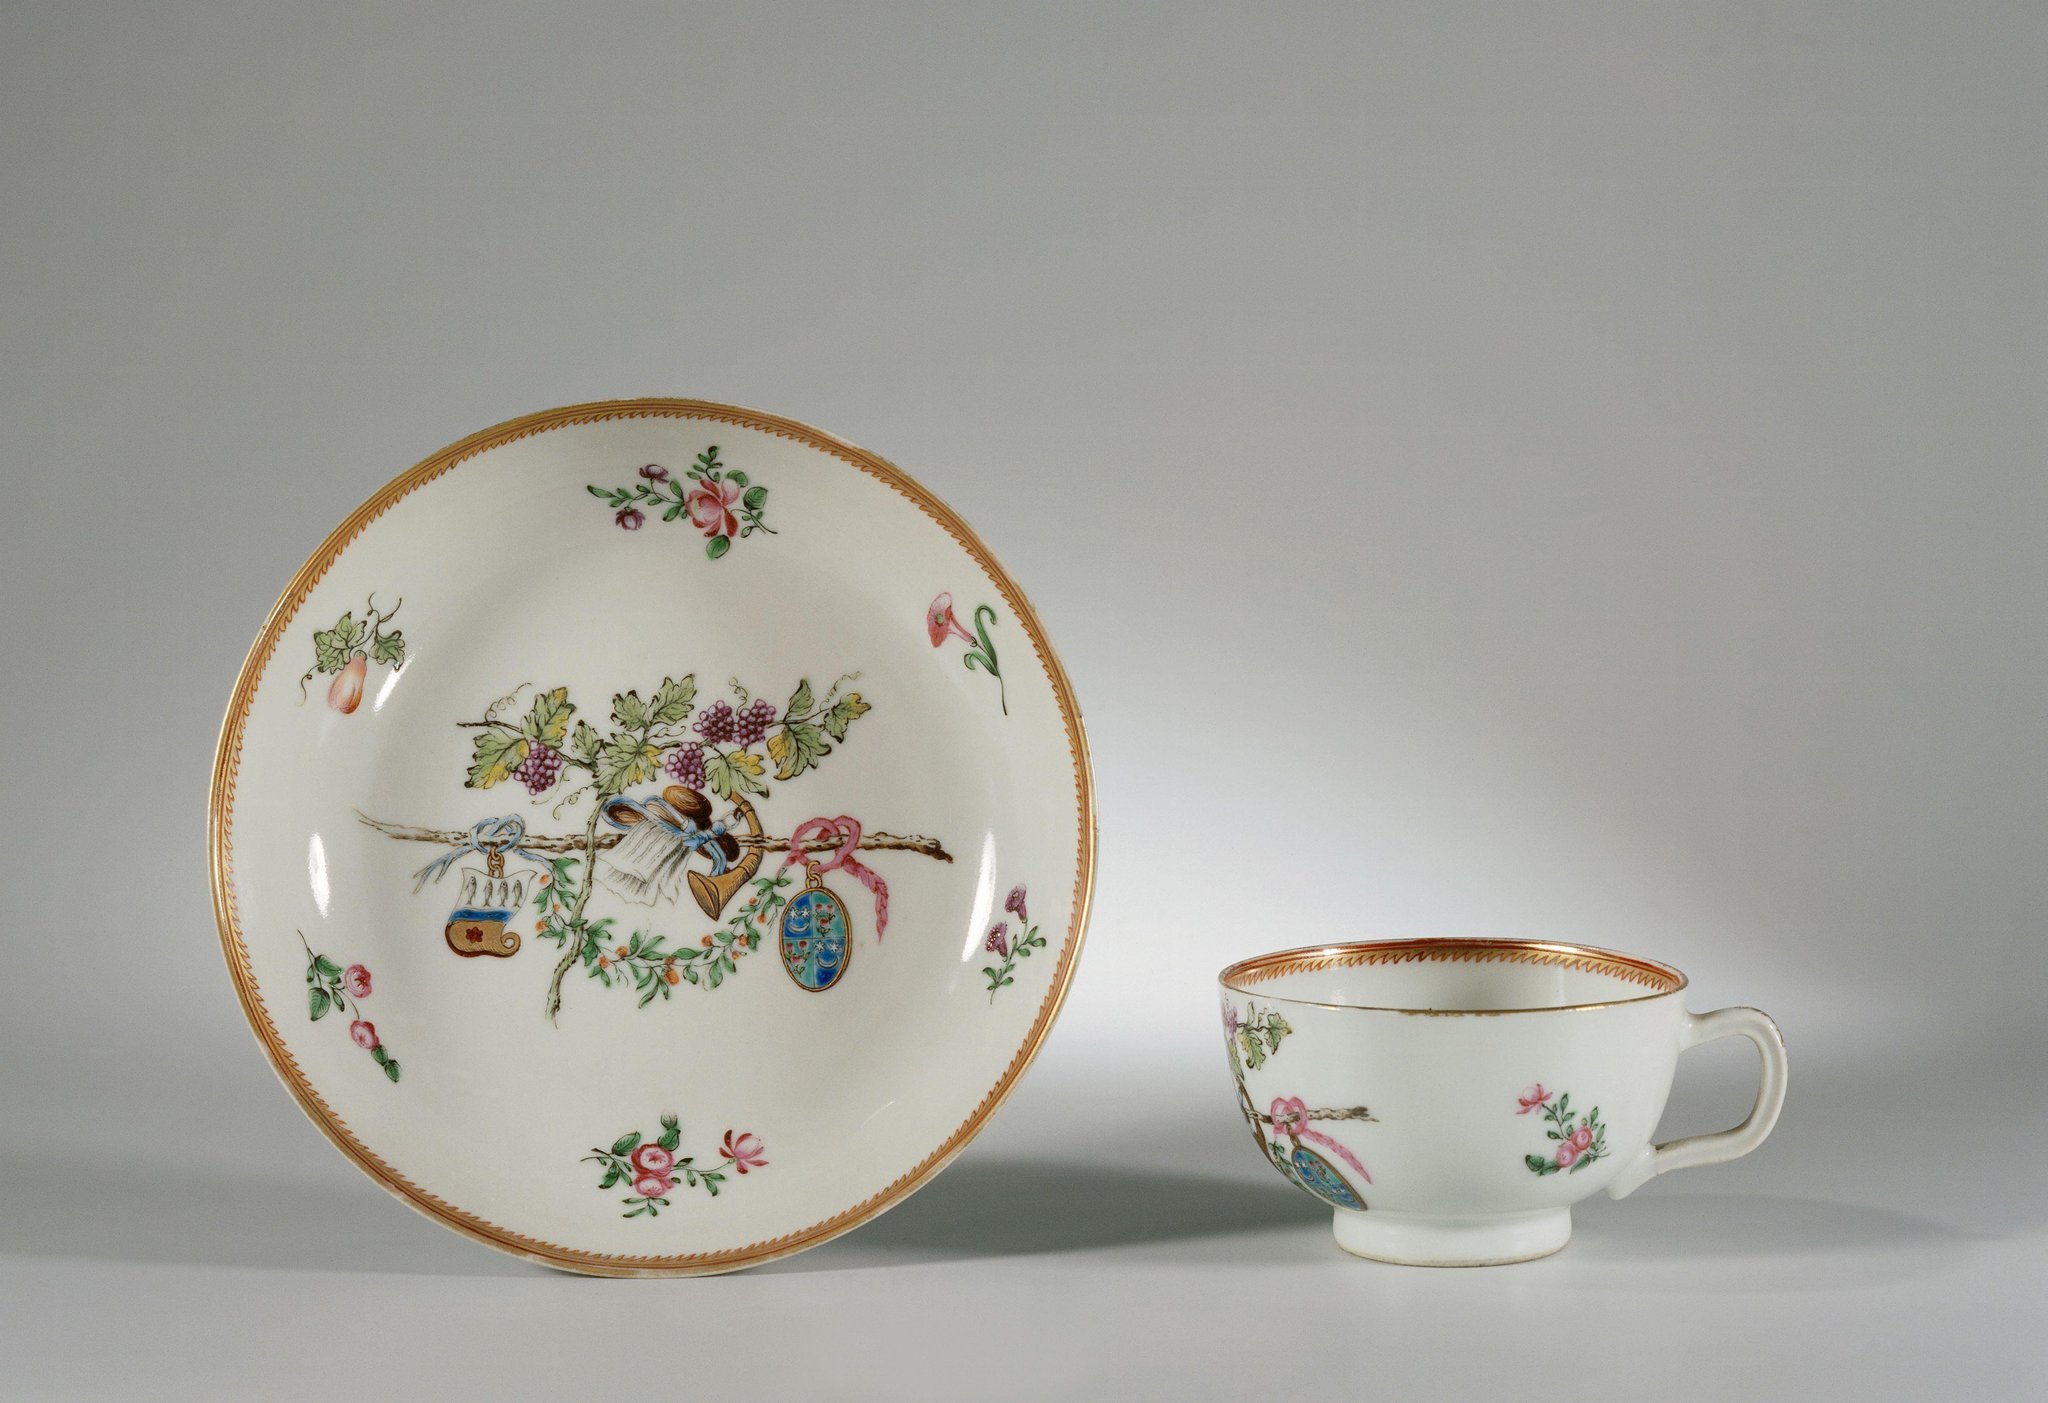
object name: cup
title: Cup with handle with the arms of the Visvliet and Sluymer families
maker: Anonymous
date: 1777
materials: glaze, gold, paint, porcelain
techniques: firing, gilding, turning, vitrification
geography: china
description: In het centrum hangen twee wapens, verbonden door een guirlande, aan bloem- en vruchtentakken. Het wapen links is van de familie Van Visvliet en is opgedeeld in twee velden met vissen en een roos. Het wapen rechts is van de familie Sluijmer en is opgedeeld in vier velden, met hemellichamen, en rode bloemen. Aan de takken zijn, behalve de wapens, een dameshoed, een blad papier en een hoorn bevestigd. De kop en schotel zijn verder versierd met strooibloemen en een rand in goud.